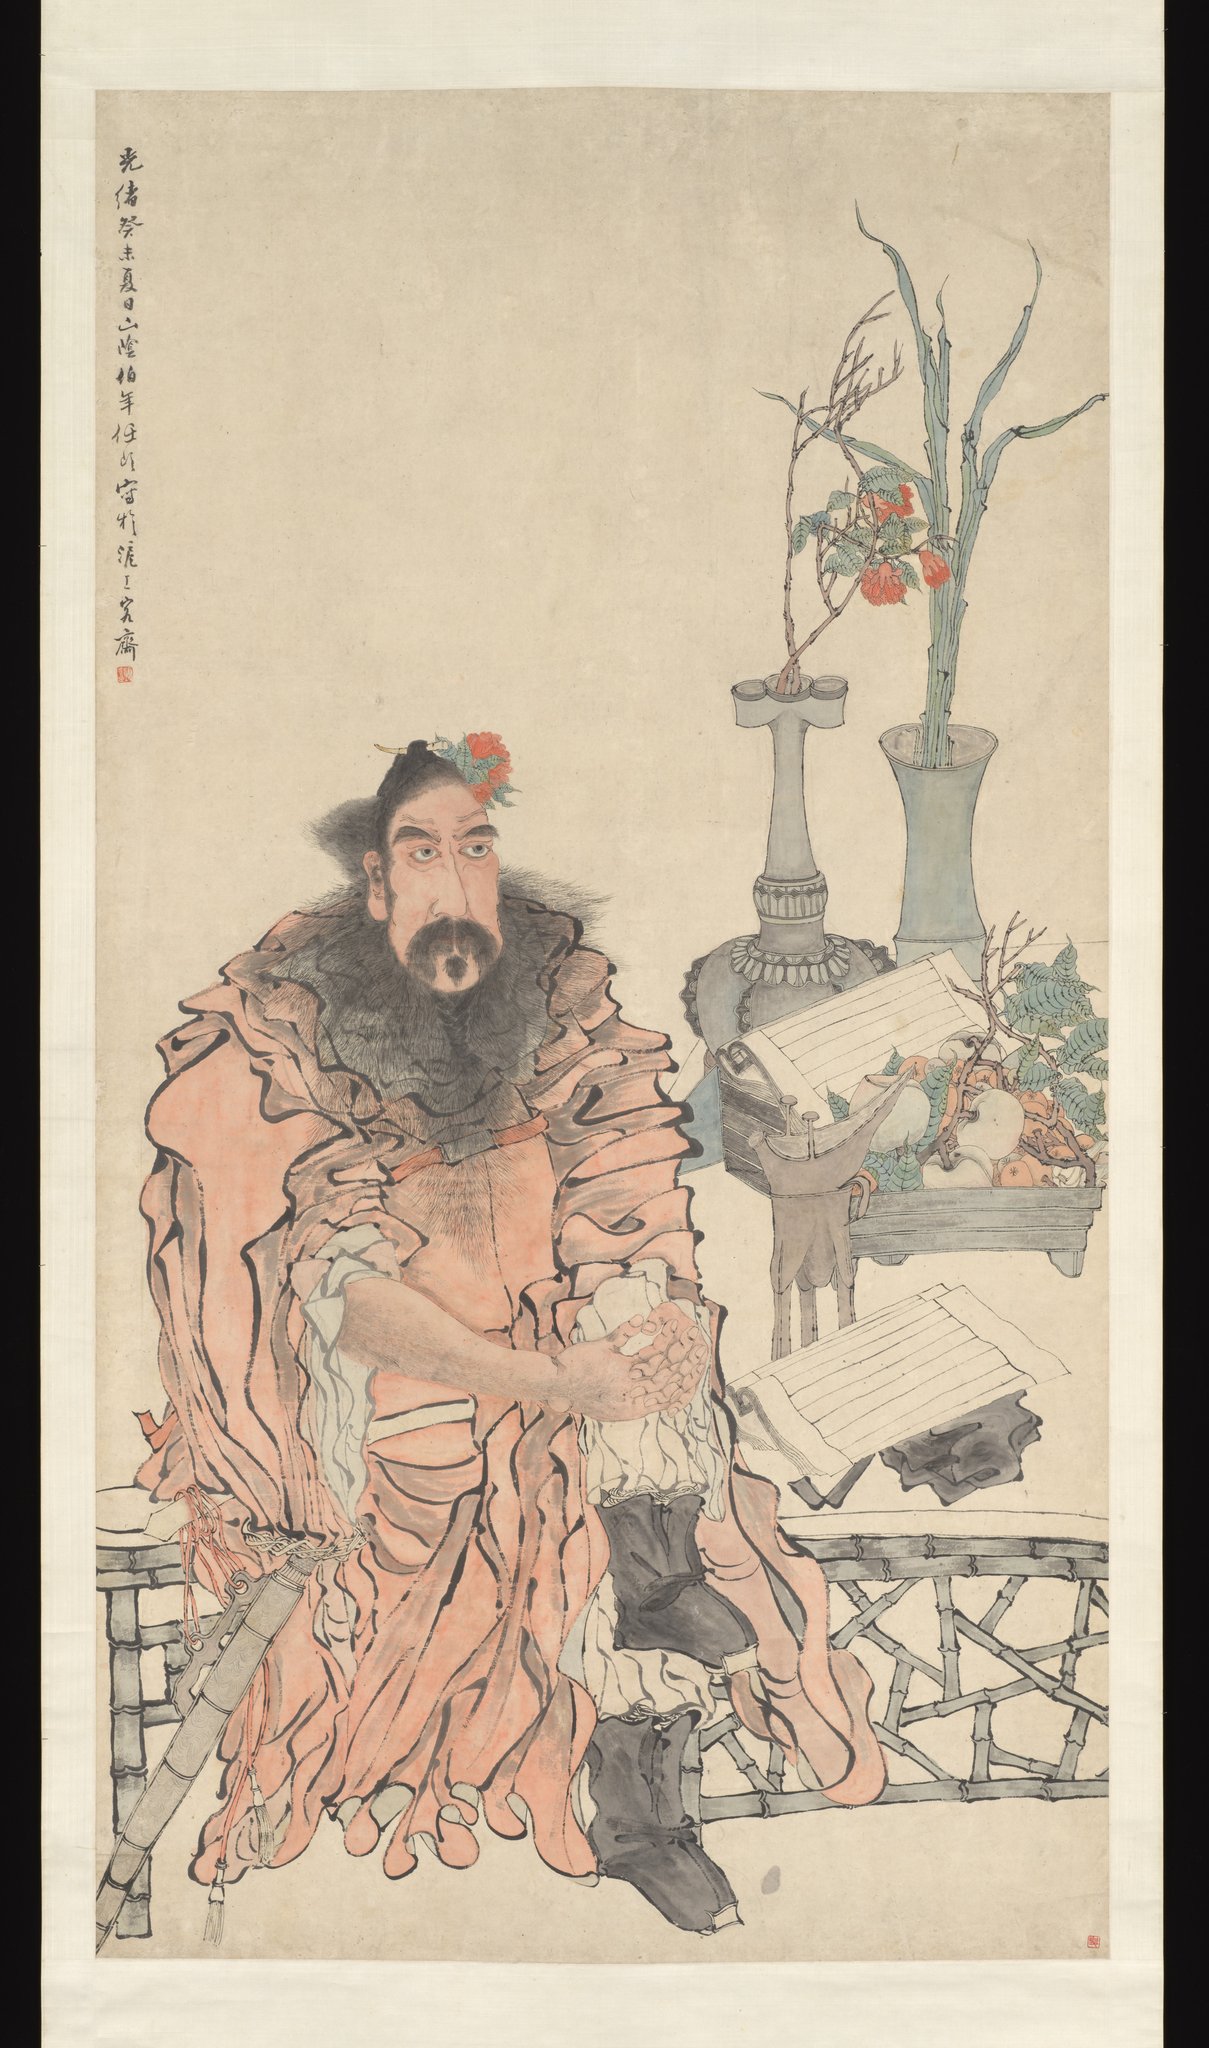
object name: hanging scroll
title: Zhong Kui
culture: chinese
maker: ren yi (ren bonian)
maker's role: artist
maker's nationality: chinese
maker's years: 1840-1896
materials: ink, paper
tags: men